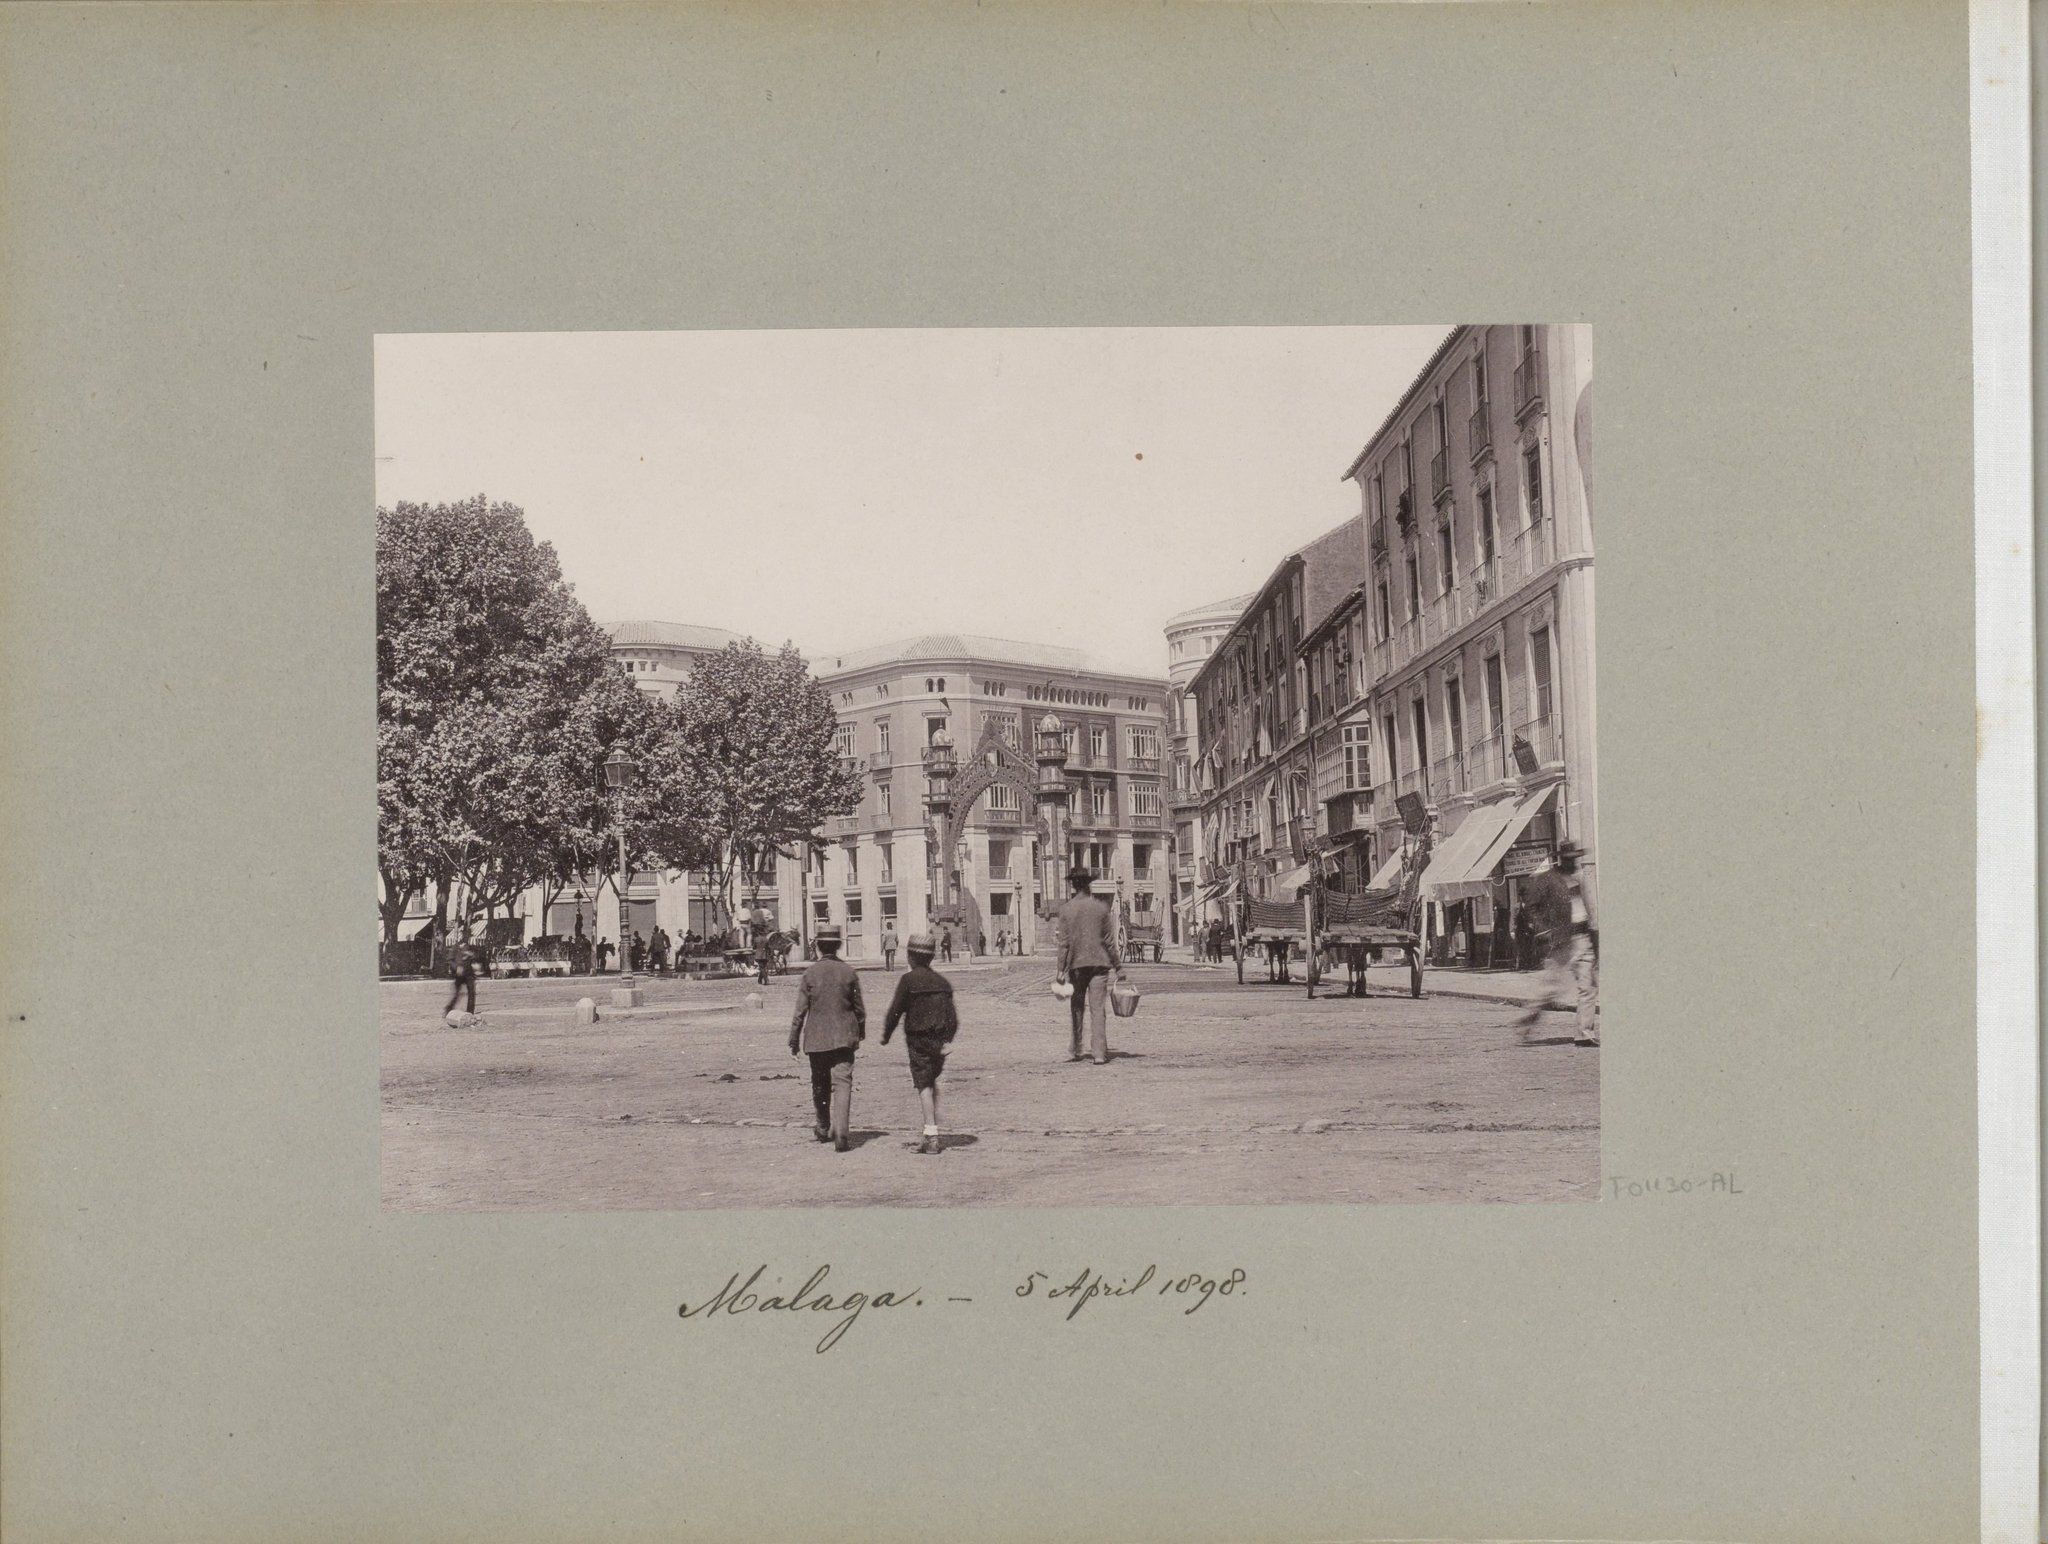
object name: photograph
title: Straatgezicht in Malaga met op de achtergrond een poort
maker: Anonymous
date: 1891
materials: paper, ink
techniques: photograph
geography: málaga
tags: gate, entrance, street (+ city(-scape) with figures, staffage)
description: Onderdeel van Reisalbum met foto's van bezienswaardigheden in Frankrijk, Spanje, Italië, Duitsland, Zwitserland en Oostenrijk.